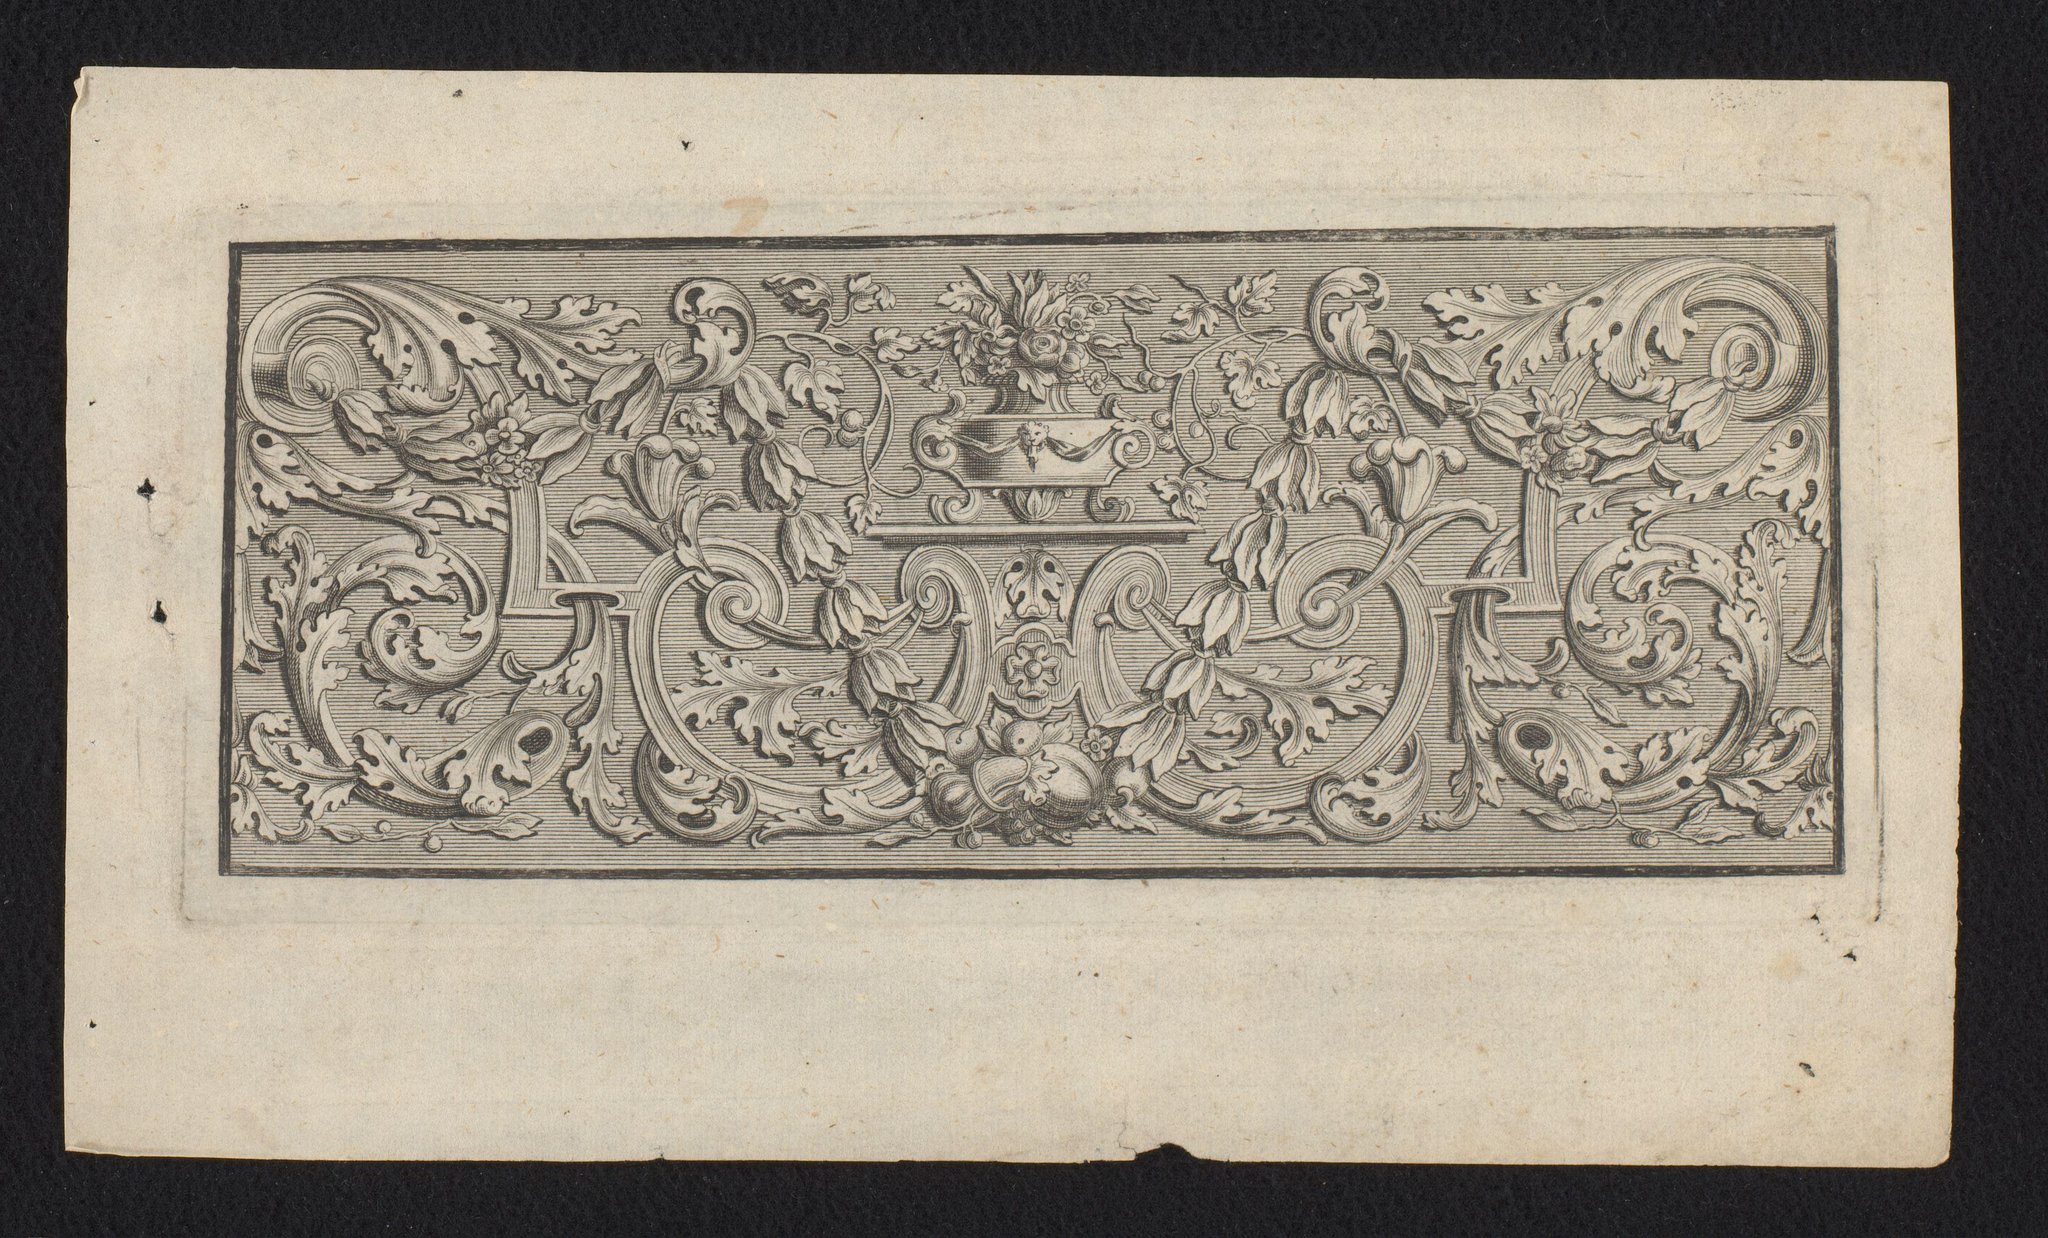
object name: print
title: Vlechtwerk met vaas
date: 1705-1710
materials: paper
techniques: engraving, etching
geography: nuremberg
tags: 'laub- und bandelwerk' ~ ornament, flowers in a vase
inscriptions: collector's mark: Lugt 2760, collector's mark: Lugt 2228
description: Vlechtwerk met bladmotieven. In het midden een vaas met leeuw en bloemen.